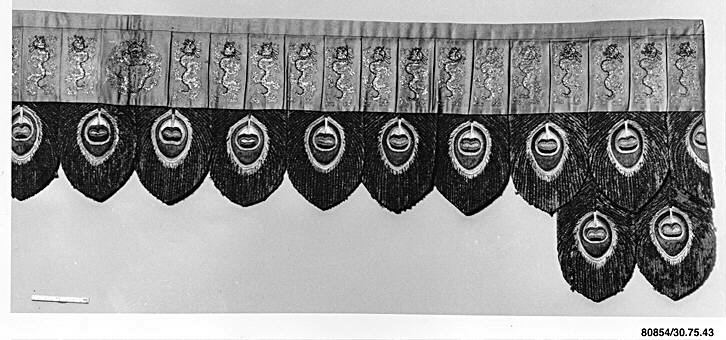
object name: valance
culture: chinese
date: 1701-1800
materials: feather, metal thread, silk